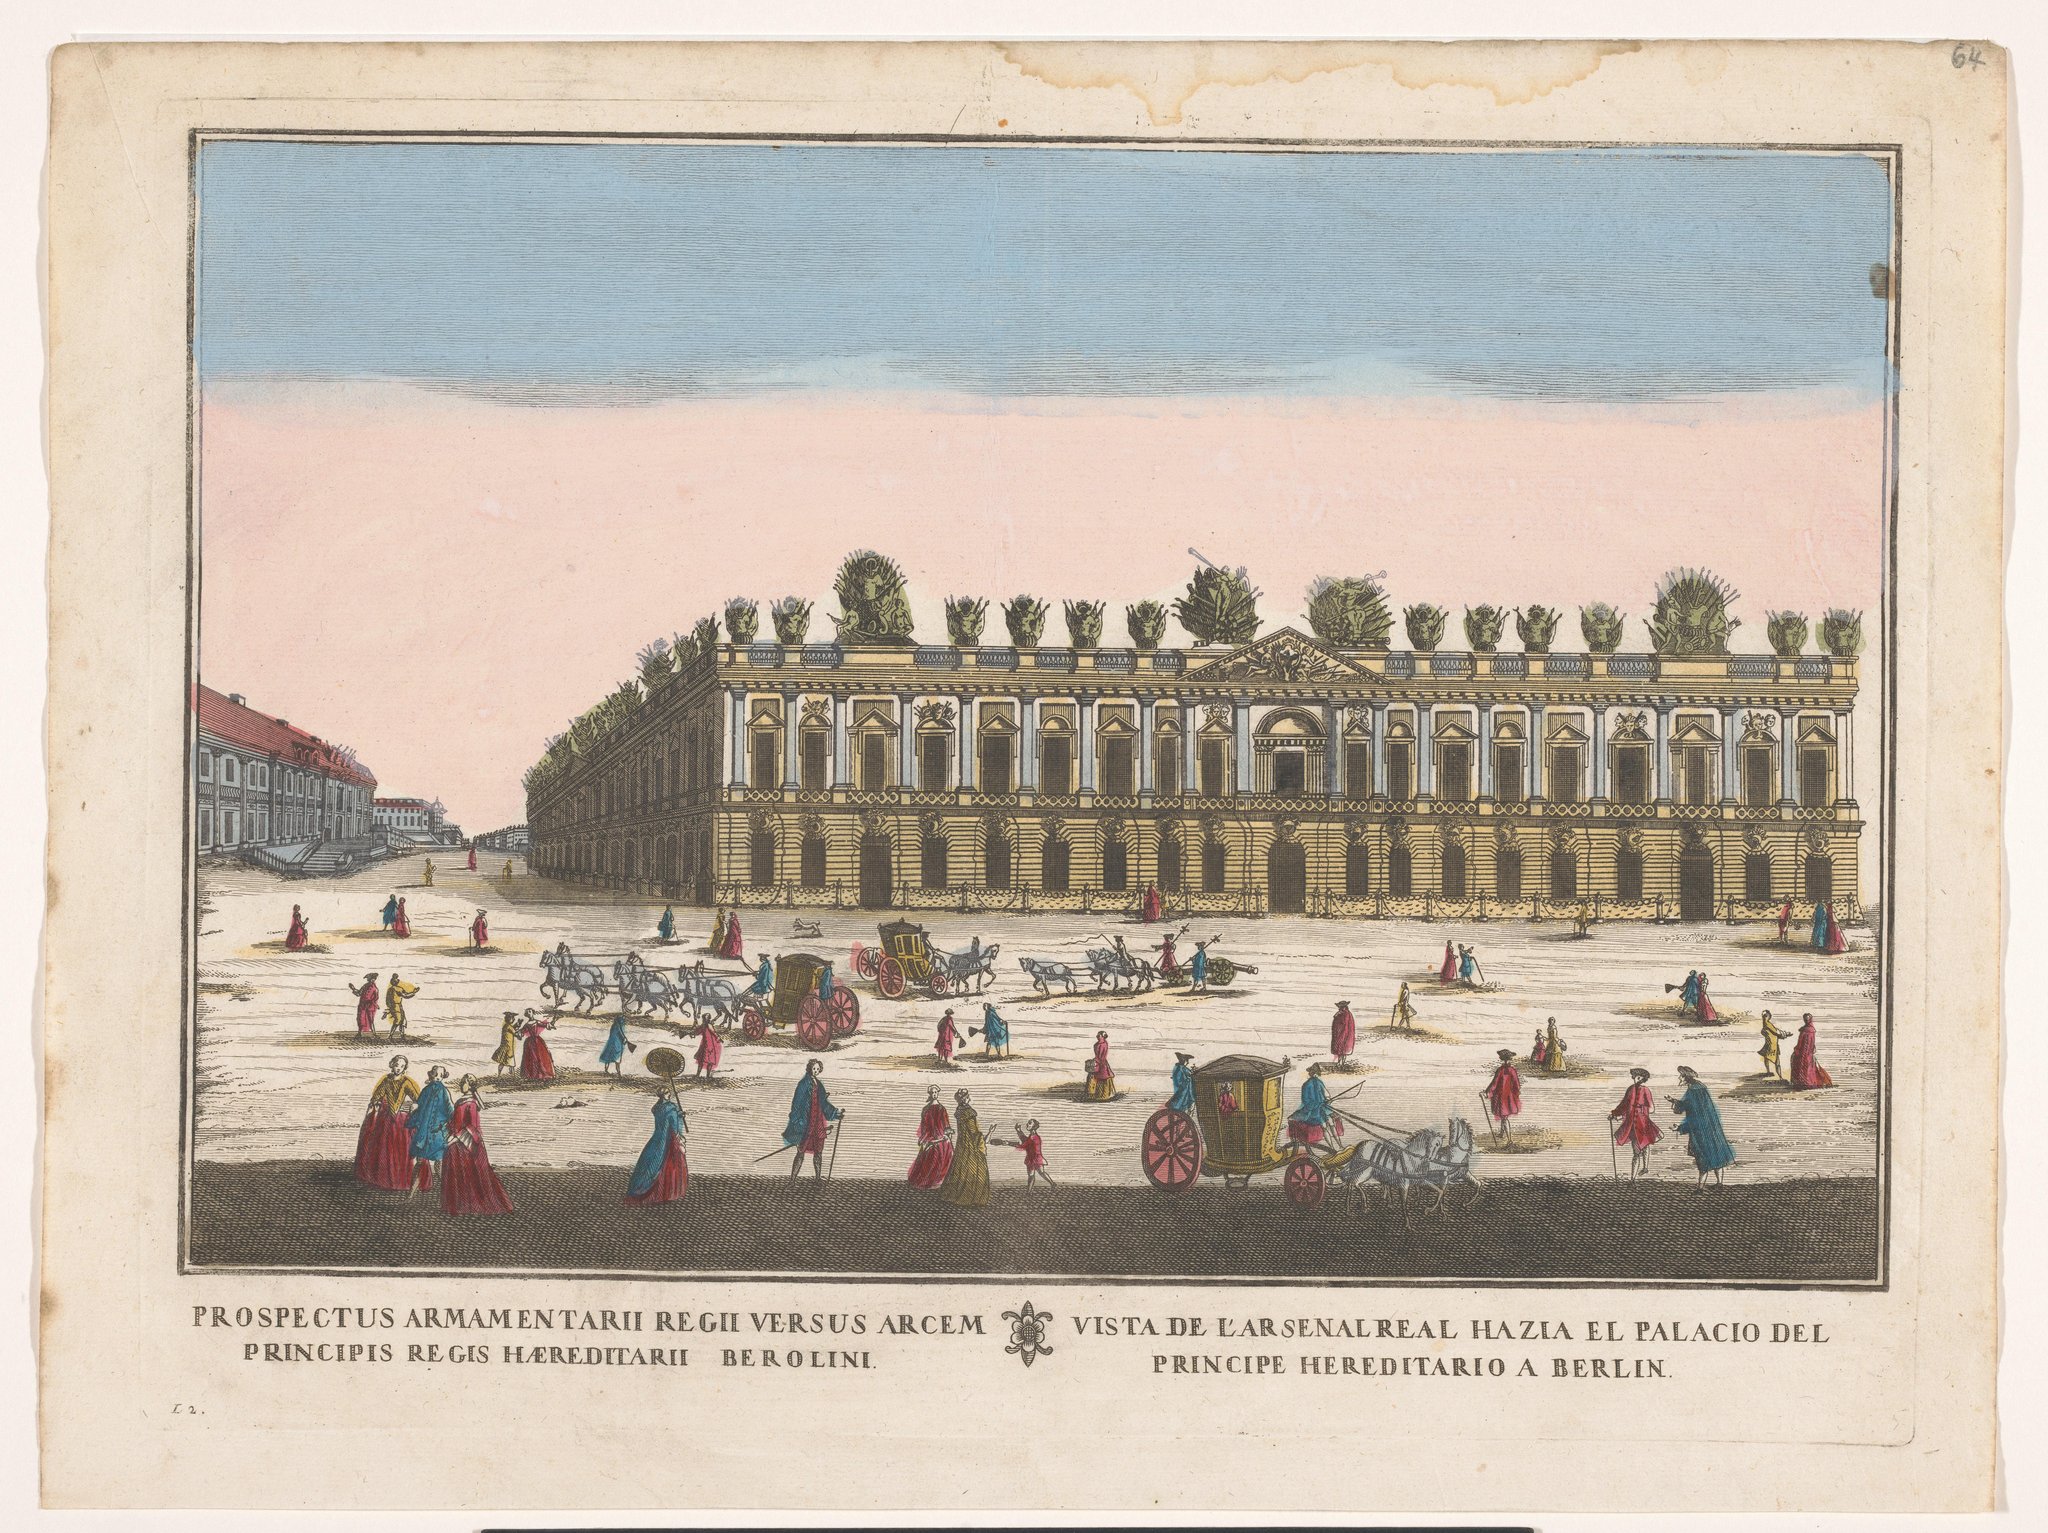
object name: print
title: Vista de l'Arsenal Real hazia el Palacio del Principe Hereditario a Berlin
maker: Anonymous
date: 1700-1799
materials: paper, watercolor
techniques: brush, etching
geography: bassano del grappa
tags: palace, square, place, circus, etc. (+ city(-scape) with figures, staffage), ammunition store, arsenal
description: Op de achtergrond links het Kronprinzenpalais. Linksonder genummerd: L 2.